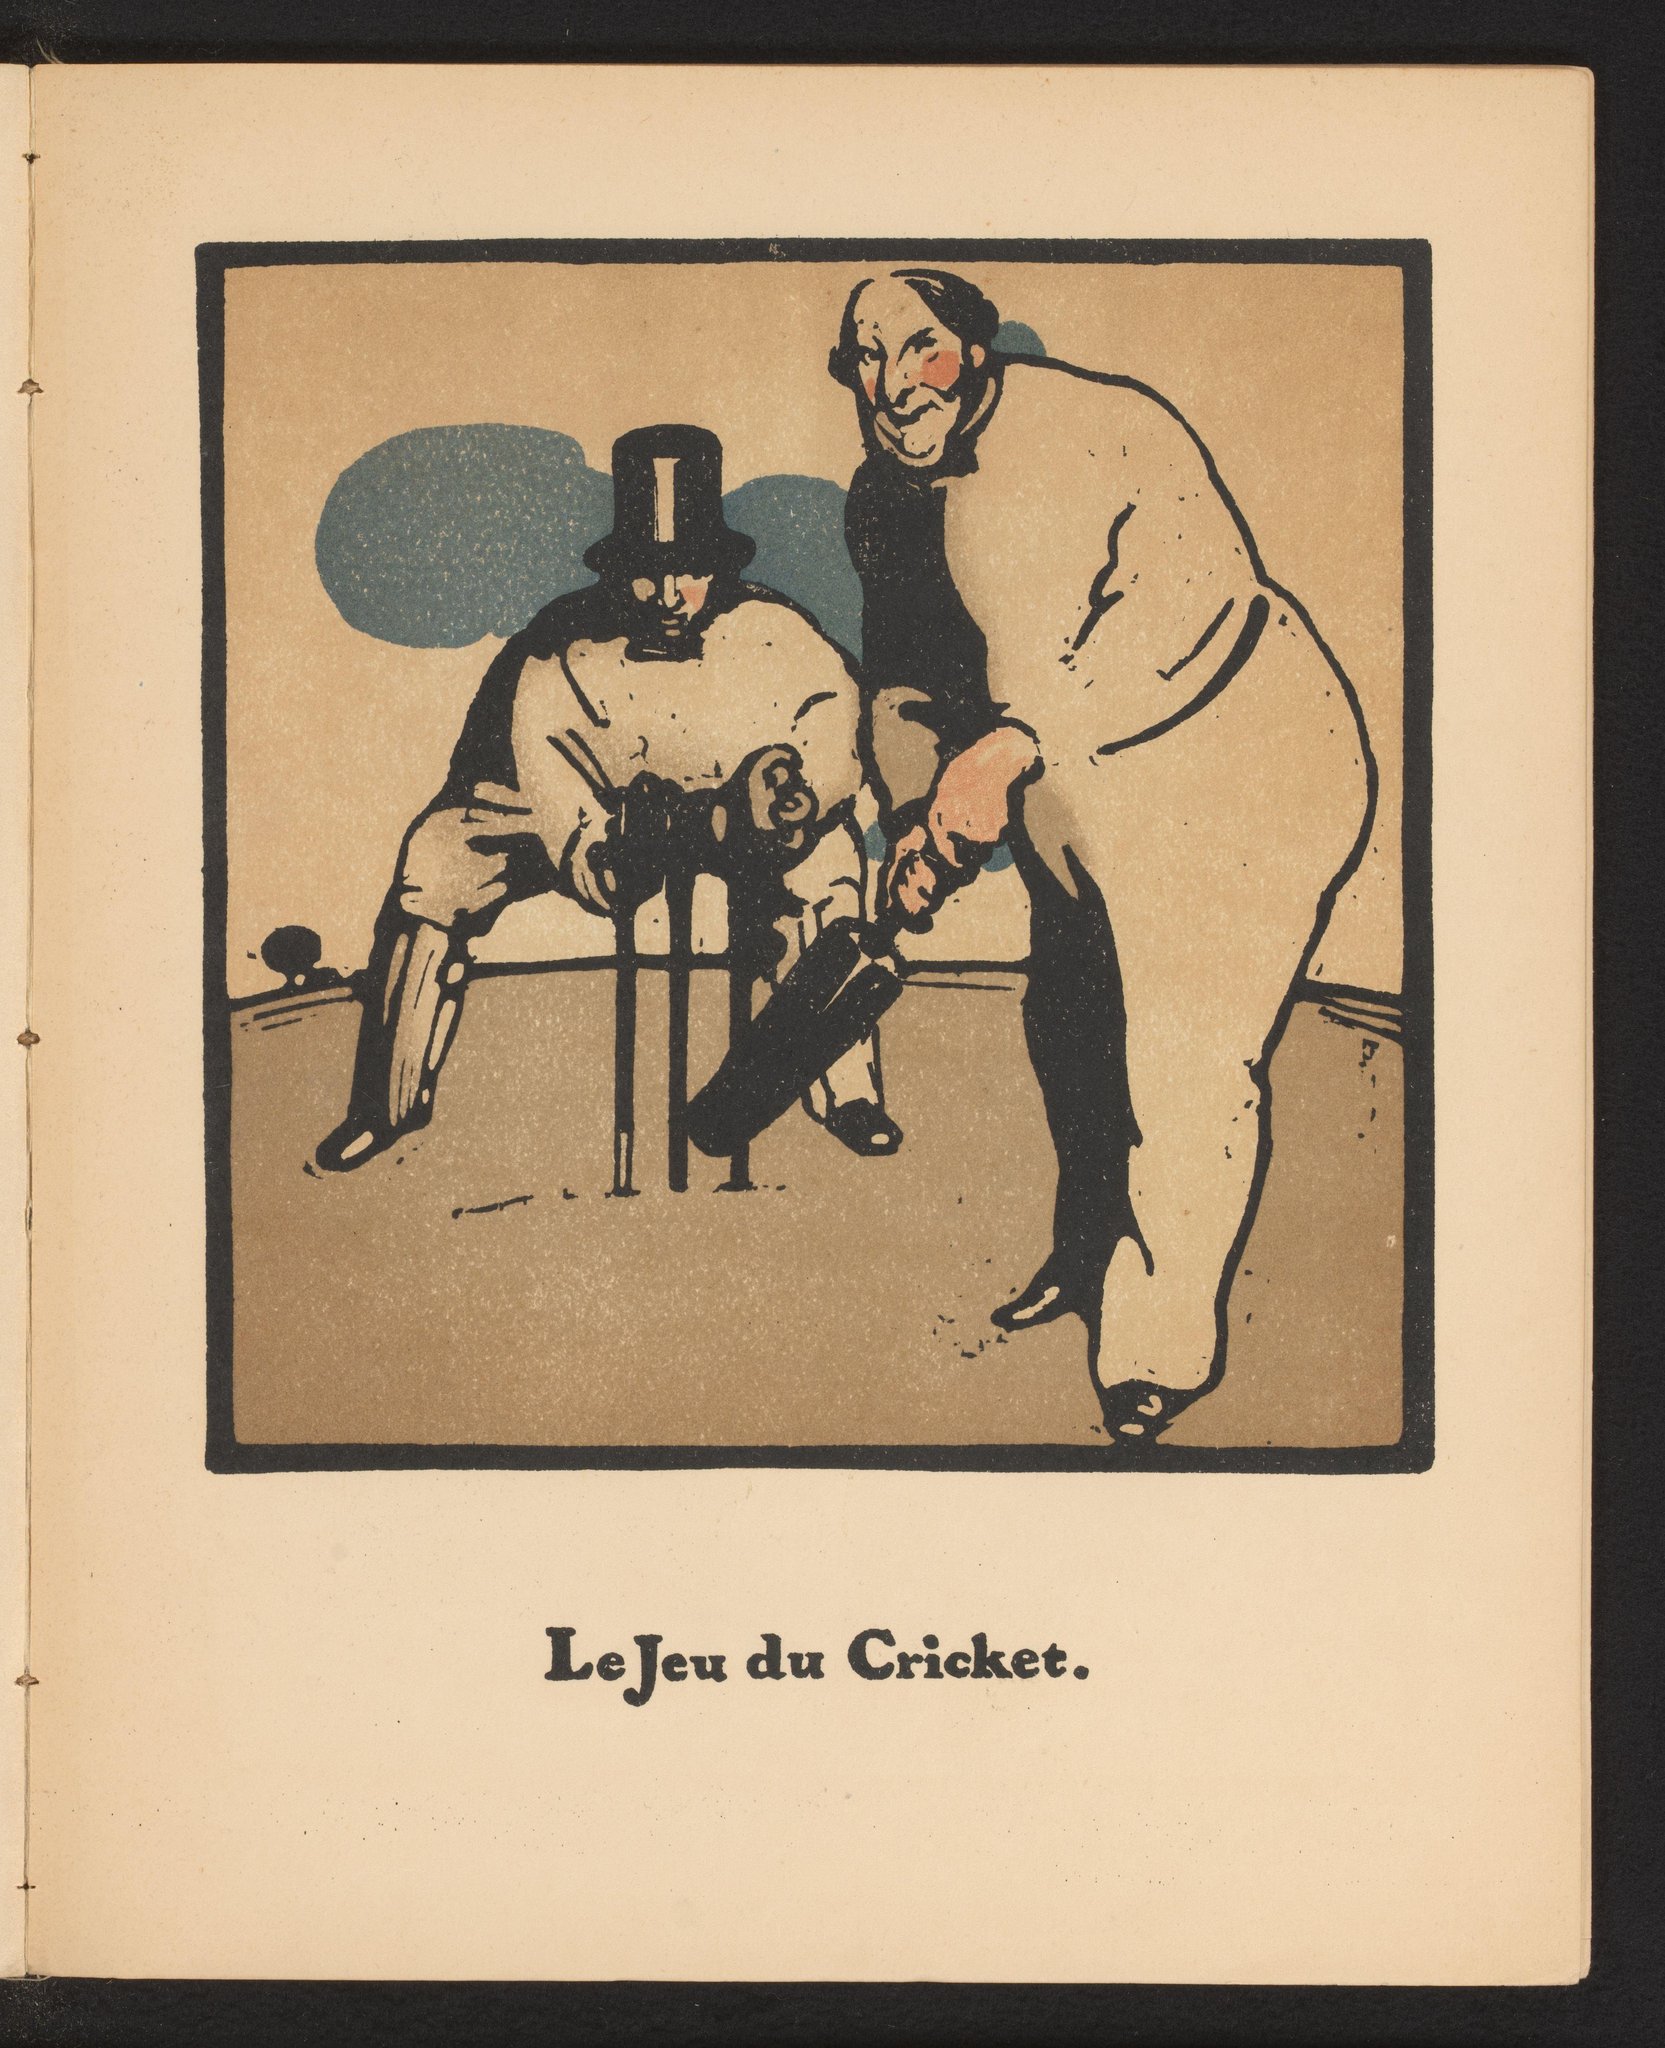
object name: page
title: Almanach de douze Sports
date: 1898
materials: paper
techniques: lithograph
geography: paris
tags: calendar, almanac, cricket (ball game)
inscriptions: : ‘Juillet/ Dimanche - 3 10 17 24 31/ Lundi - 4 11 18 (...)’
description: Prent maakt deel uit van een boek. Illustratie bij kalendermaand op tegenoverliggende blad.